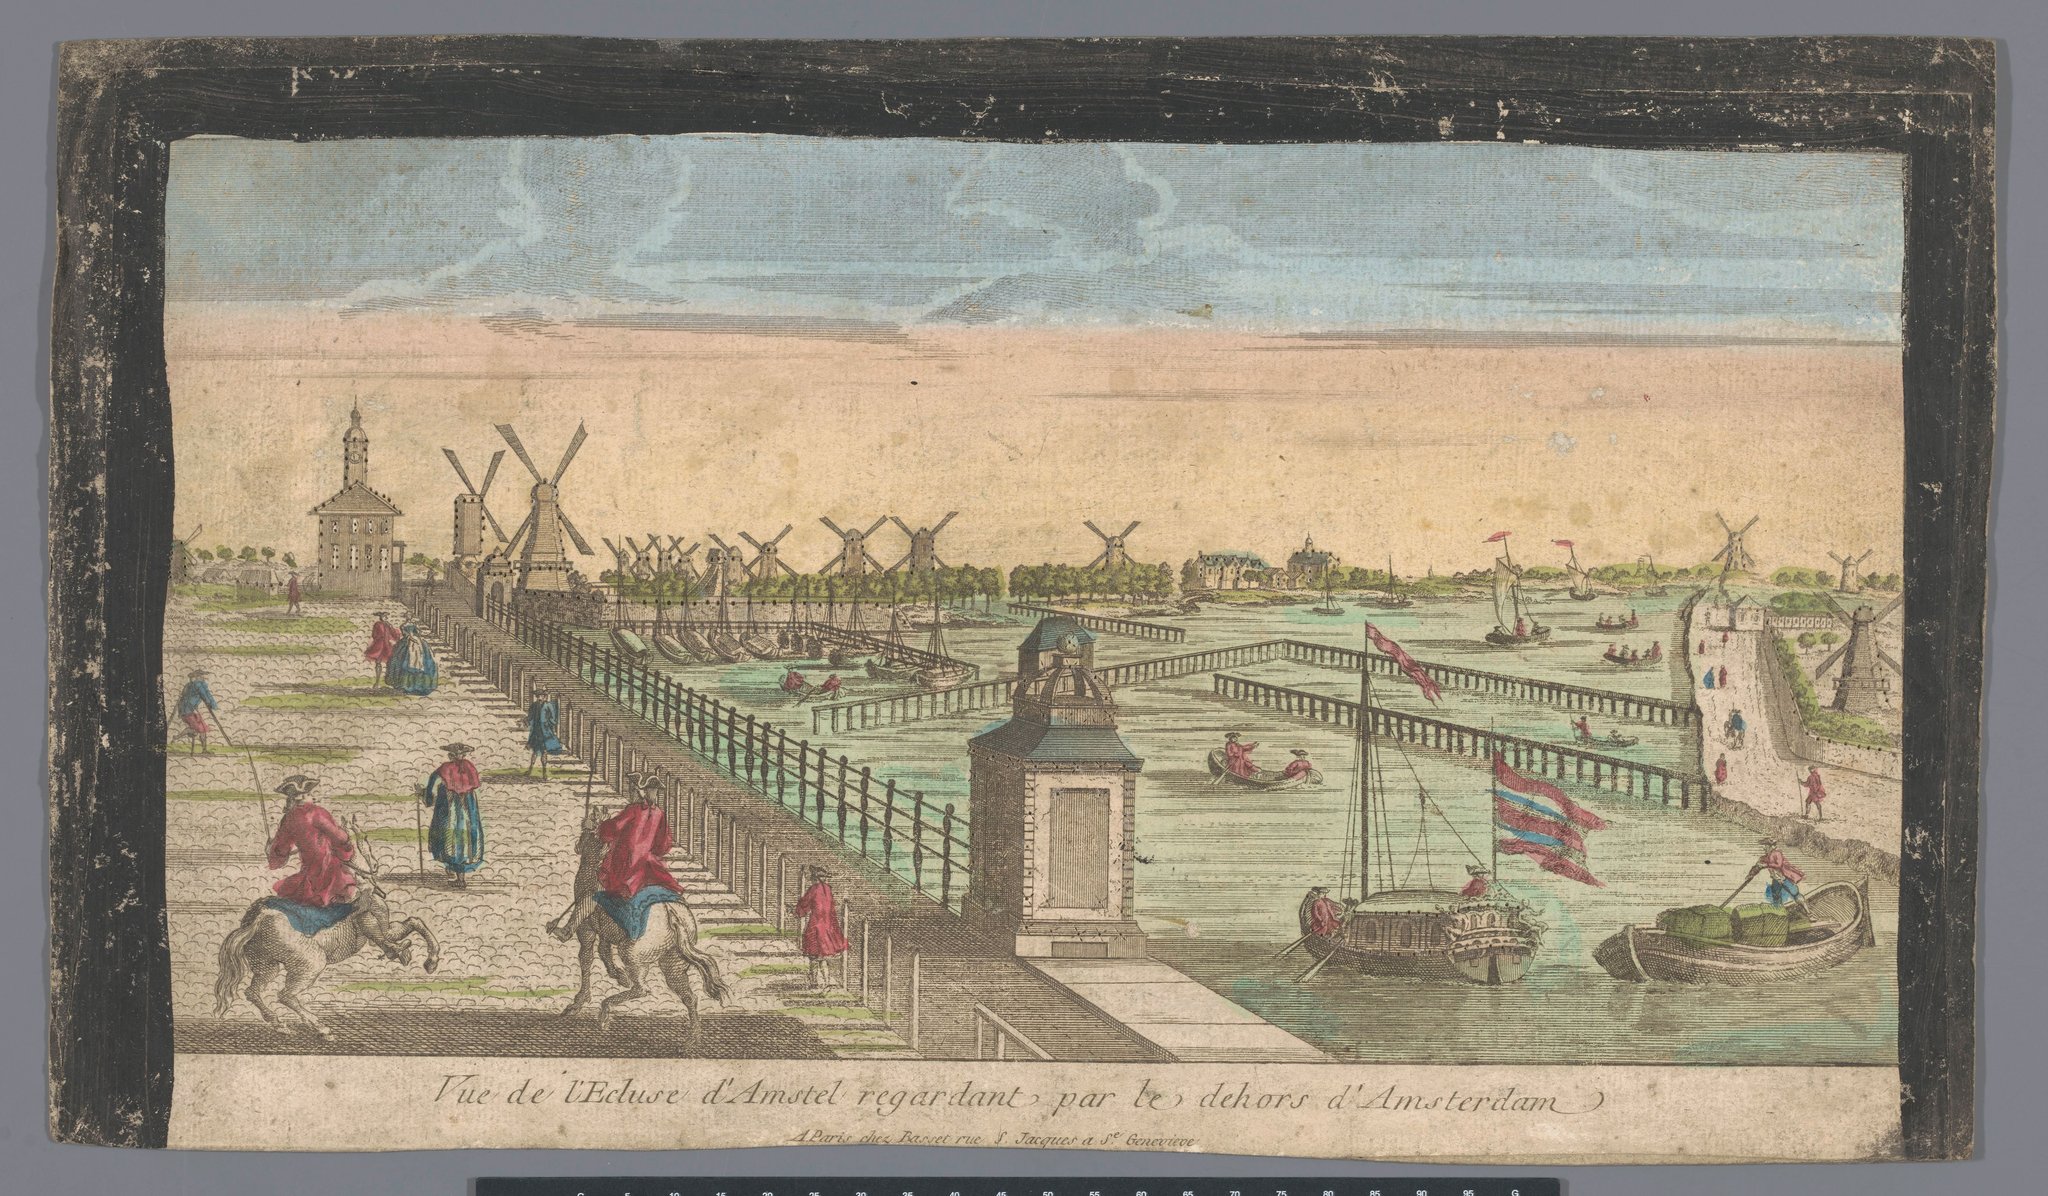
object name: opticaprent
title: Gezicht op de Hogesluis naar de Buiten-Amstel, de Amsteldijk en de molens aan de Zaagmolensloot te Amsterdam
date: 1700-1799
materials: cardboard, paint, paper, watercolor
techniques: brush, cutting, etching, perforating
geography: france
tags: sailing-ship, sailing-boat, rowing-boat, canoe, etc., gate, entrance, windmill in landscape, dikes, levee, sluice, weir (+ landscape with figures, staffage), canals, waters (in city) (+ city(-scape) with figures, staffage)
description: Links het bolwerk Westerblokhuis met molen De Groen en de Utrechtsepoort. Rechts de Weesperzijde.